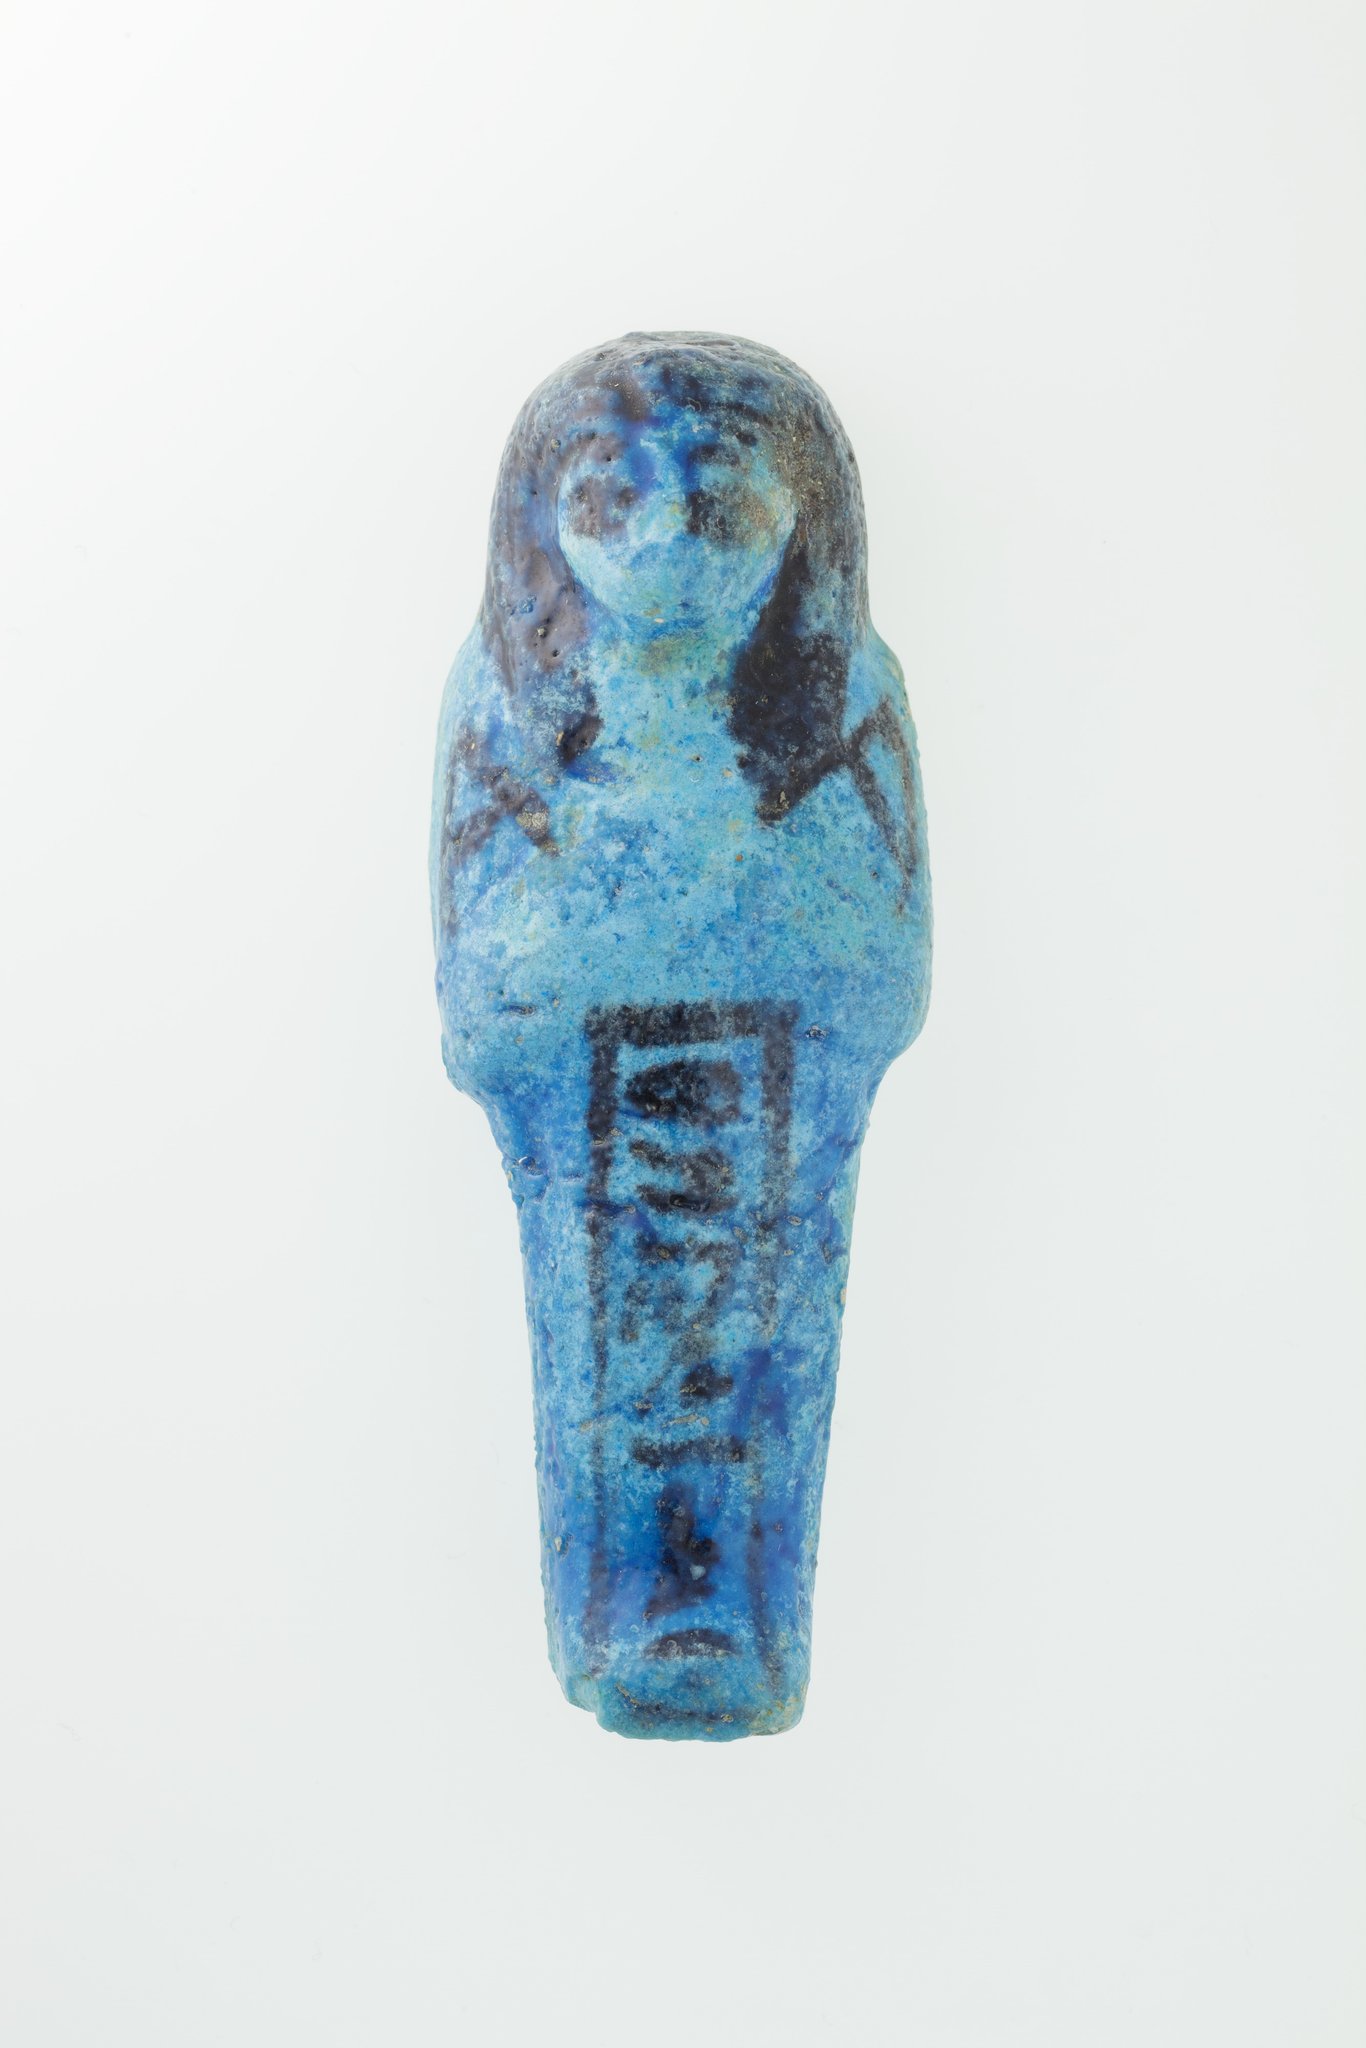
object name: shabti, worker, nauny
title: Worker Shabti of Nauny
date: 1050 BCE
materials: faience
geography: egypt